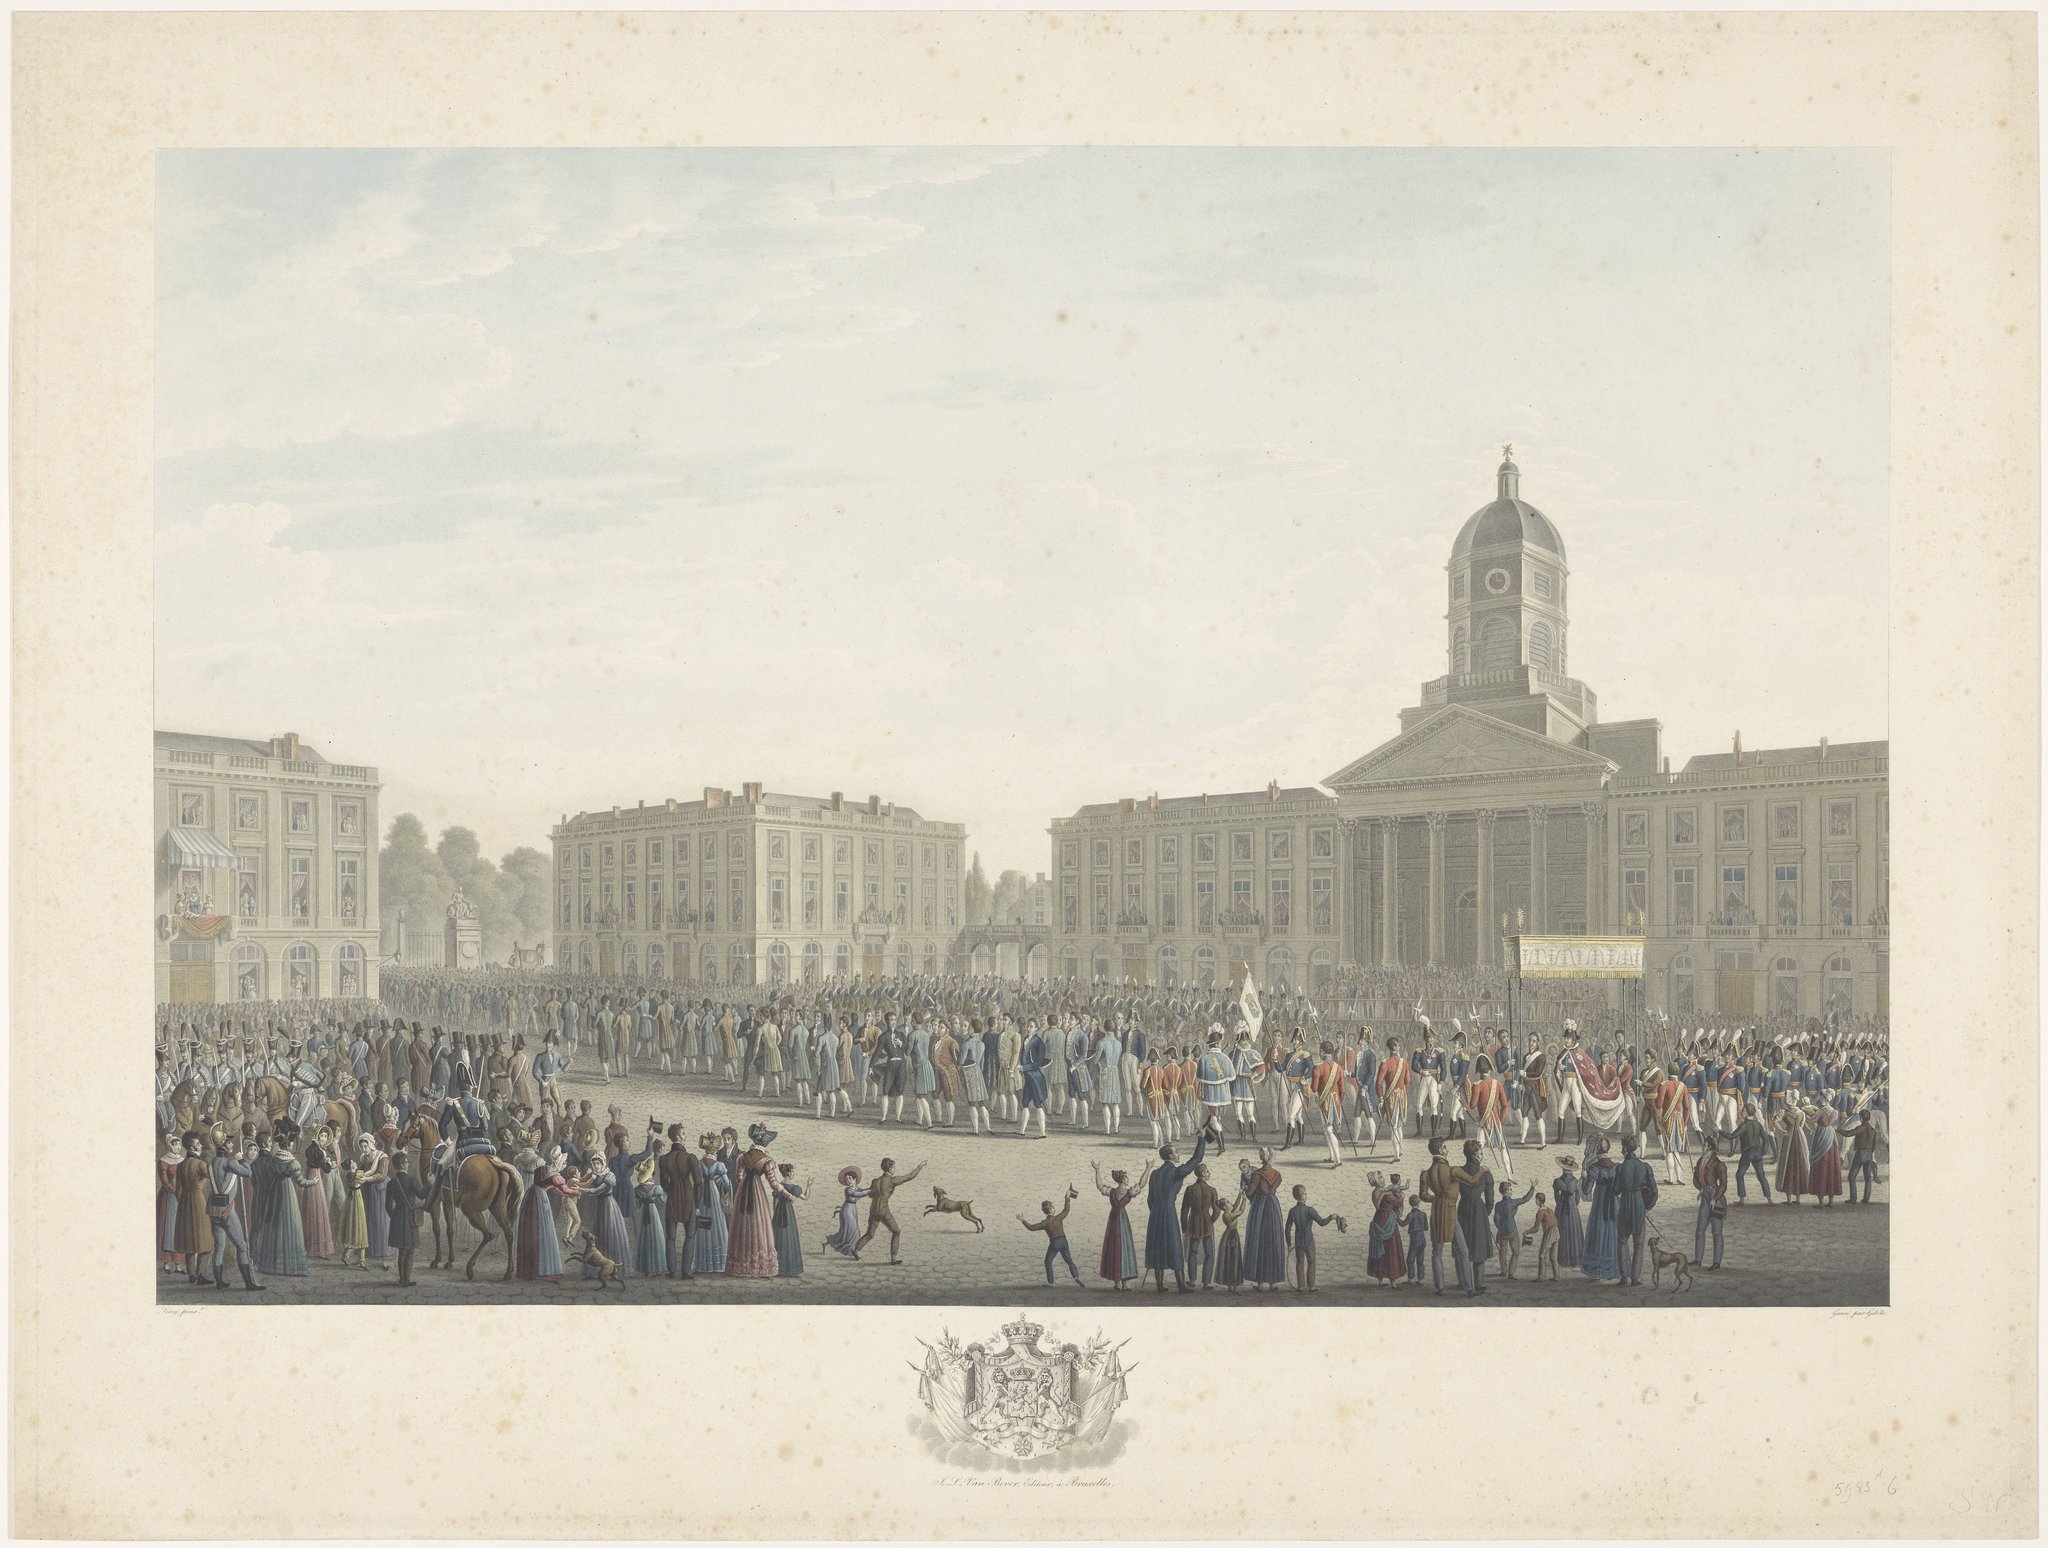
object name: print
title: Optocht van koning Willem I over het Koningsplein te Brussel op 21 september 1815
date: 1825-1826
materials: paper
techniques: aquatint, etching, hand coloring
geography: brussels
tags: the hague, berlin, william i of the netherlands, ceremonial procession, parade, pageant ~ installation of a ruler, brussels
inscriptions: workshop stamp: ‘JLVB’, collector's mark: Lugt 2228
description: Optocht van koning Willem I na de inhuldiging op het Koningsplein bij de kerk Sint-Jacob-op-Koudenberg te Brussel op 21 september 1815. De koning lopend in de stoet onder een baldakijn. Onderaan het wapen van koning Willem I. Onderdeel van een serie platen van de aankomst en inhuldiging van Willem I in Brussel.